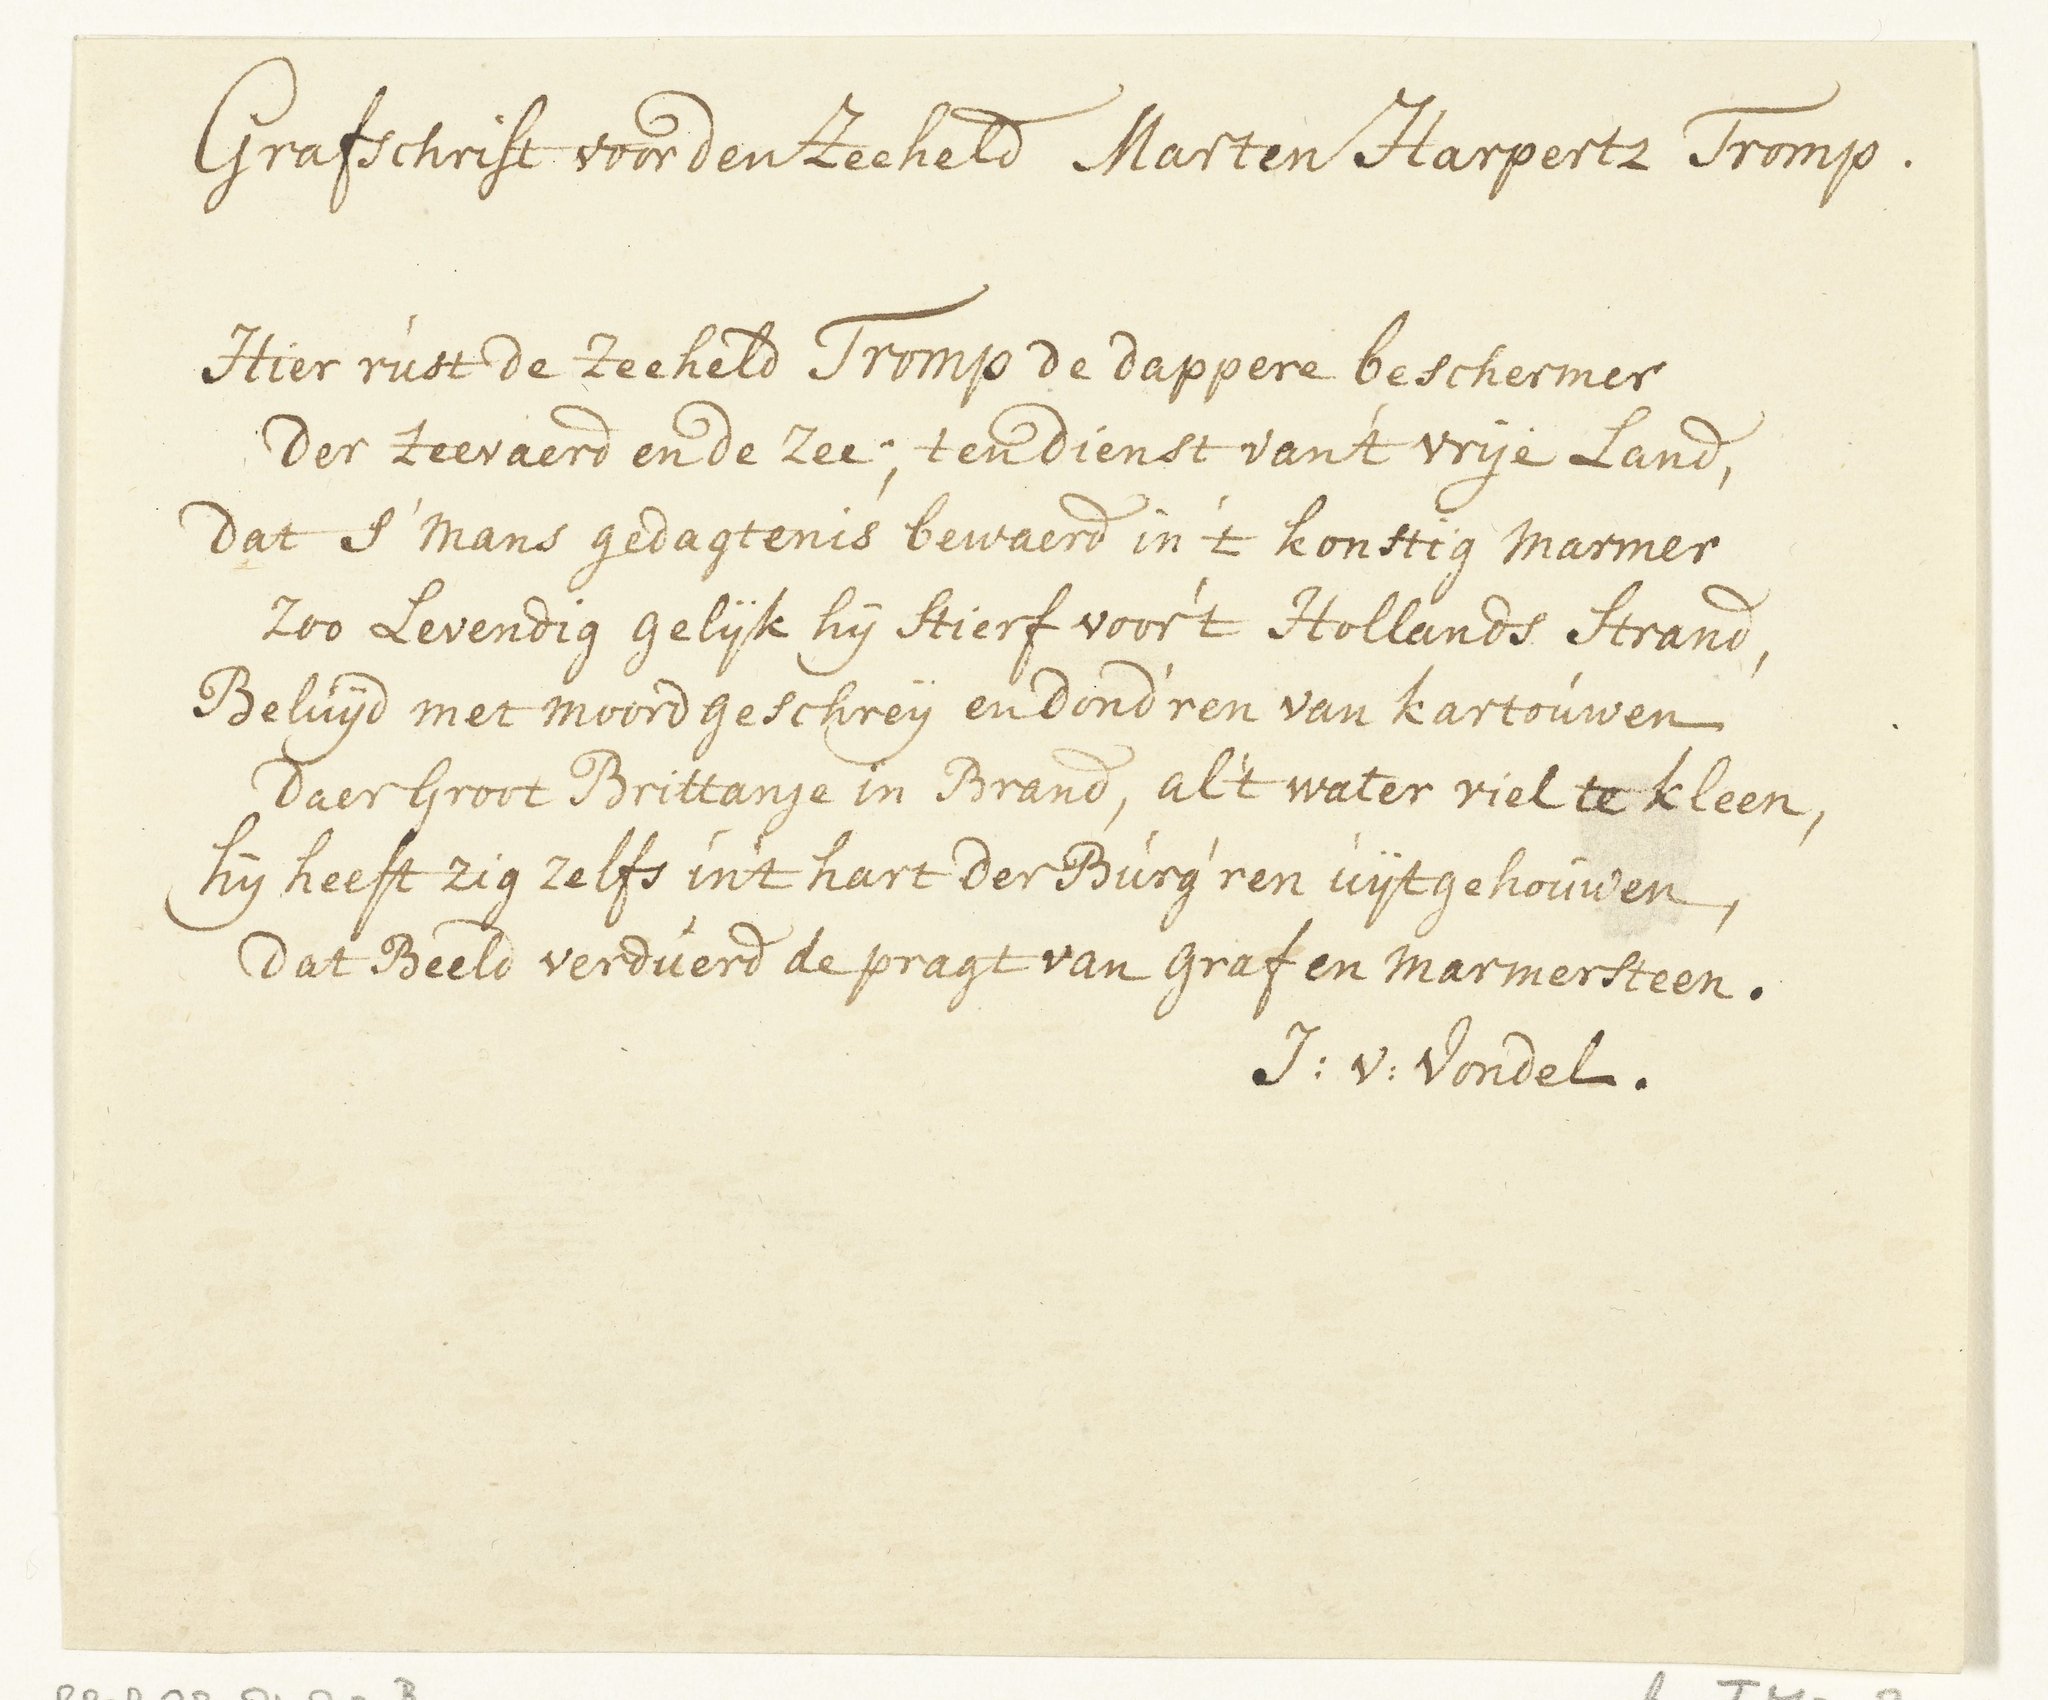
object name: manuscript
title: Grafschrift voor den Zeeheld Marten Harpertz Tromp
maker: joost van den vondel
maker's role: dichter, toneelschrijver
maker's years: 1587-1679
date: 1850-1863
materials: paper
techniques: writing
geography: netherlands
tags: brielle, maarten harpertszoon tromp, commander-in-chief, admiral (+ naval force), battle of scheveningen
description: Afschrift van het grafschrift van Vondel op het praalgraf uit 1656 van Maarten Tromp (gesneuveld in de Zeeslag bij Terheide op 10 augustus 1653) in de Oude Kerk te Delft.